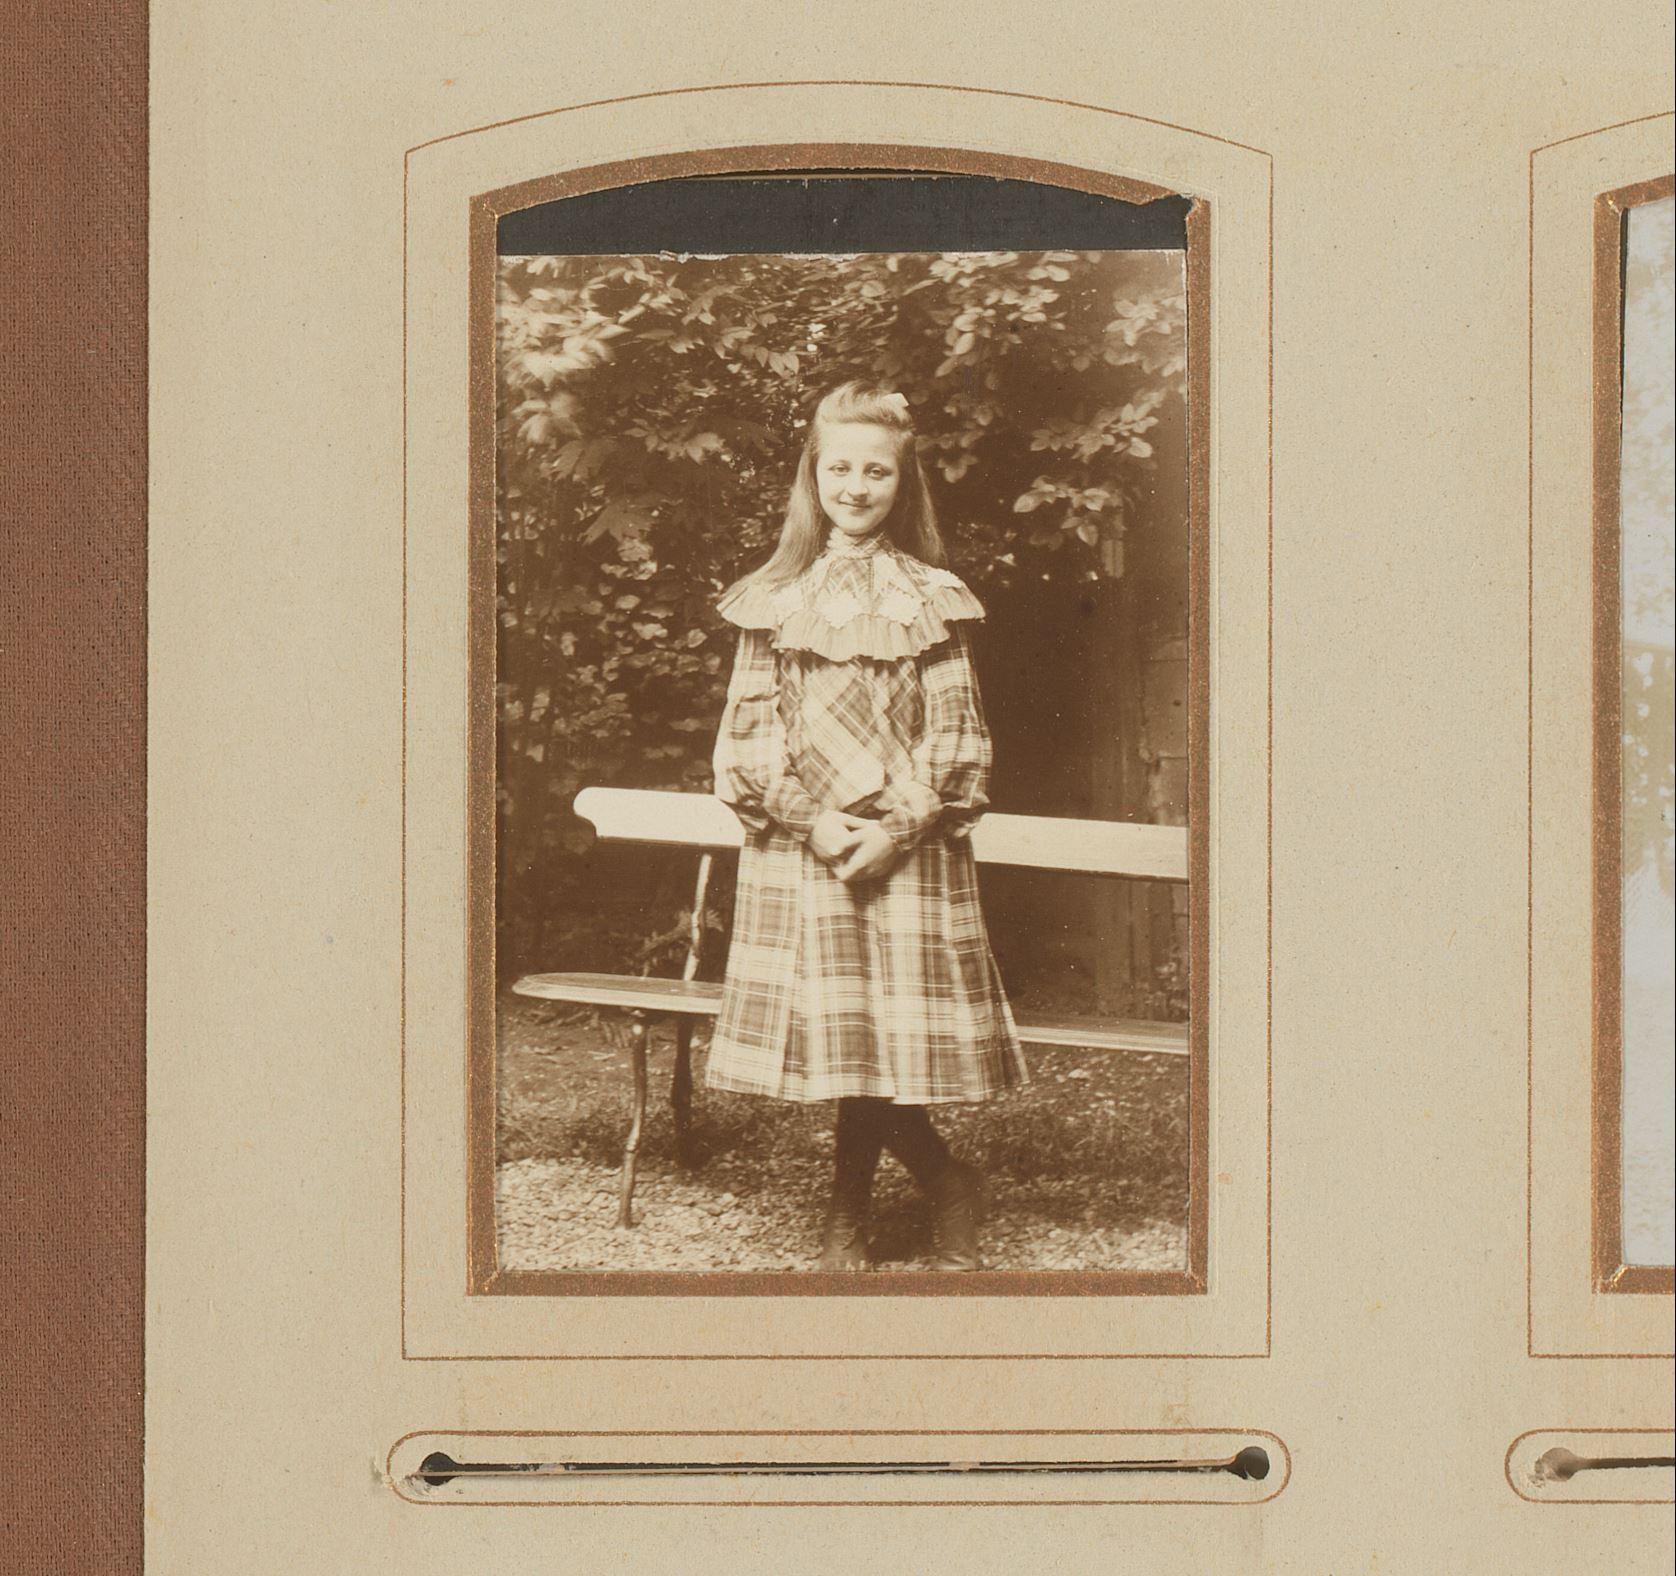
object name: album leaf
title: Portret van een meisje, staand voor een bank in een tuin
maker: Anonymous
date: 1880-1920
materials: cardboard, photographic support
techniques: collodion silver print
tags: historical persons - bb - woman, garden, girl (child between toddler and youth)